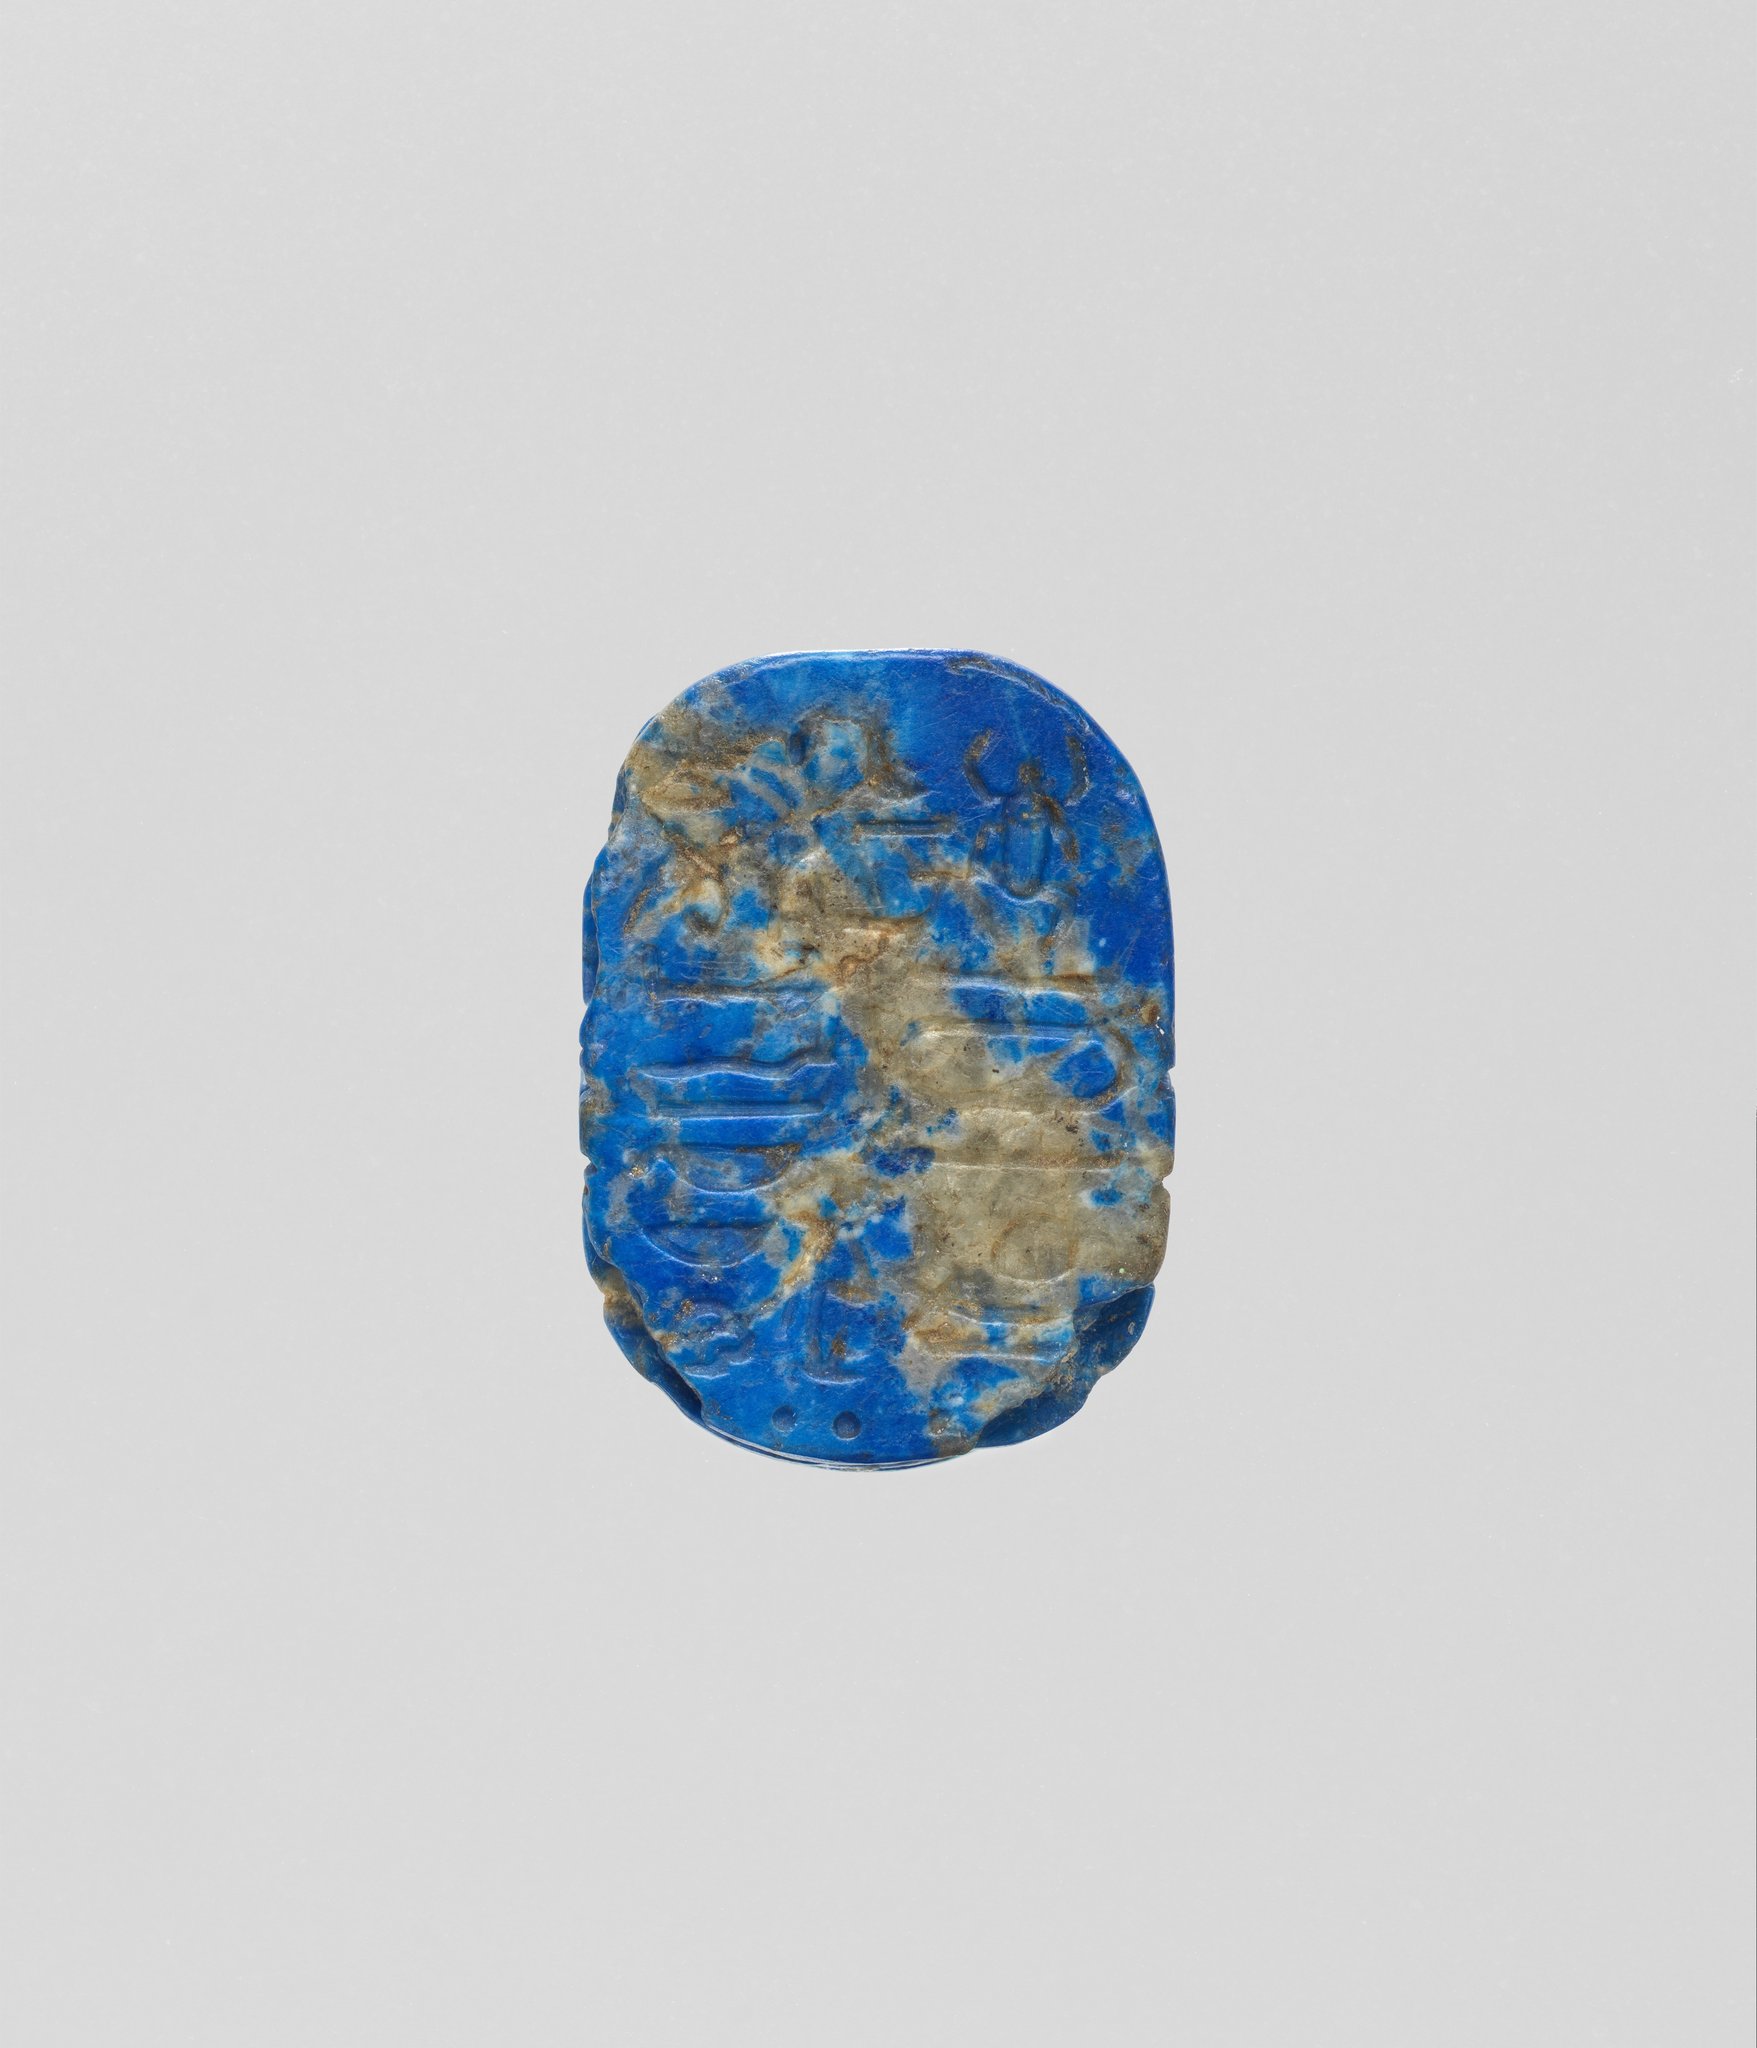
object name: scarab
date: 664-332 BCE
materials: lapis lazuli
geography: egypt